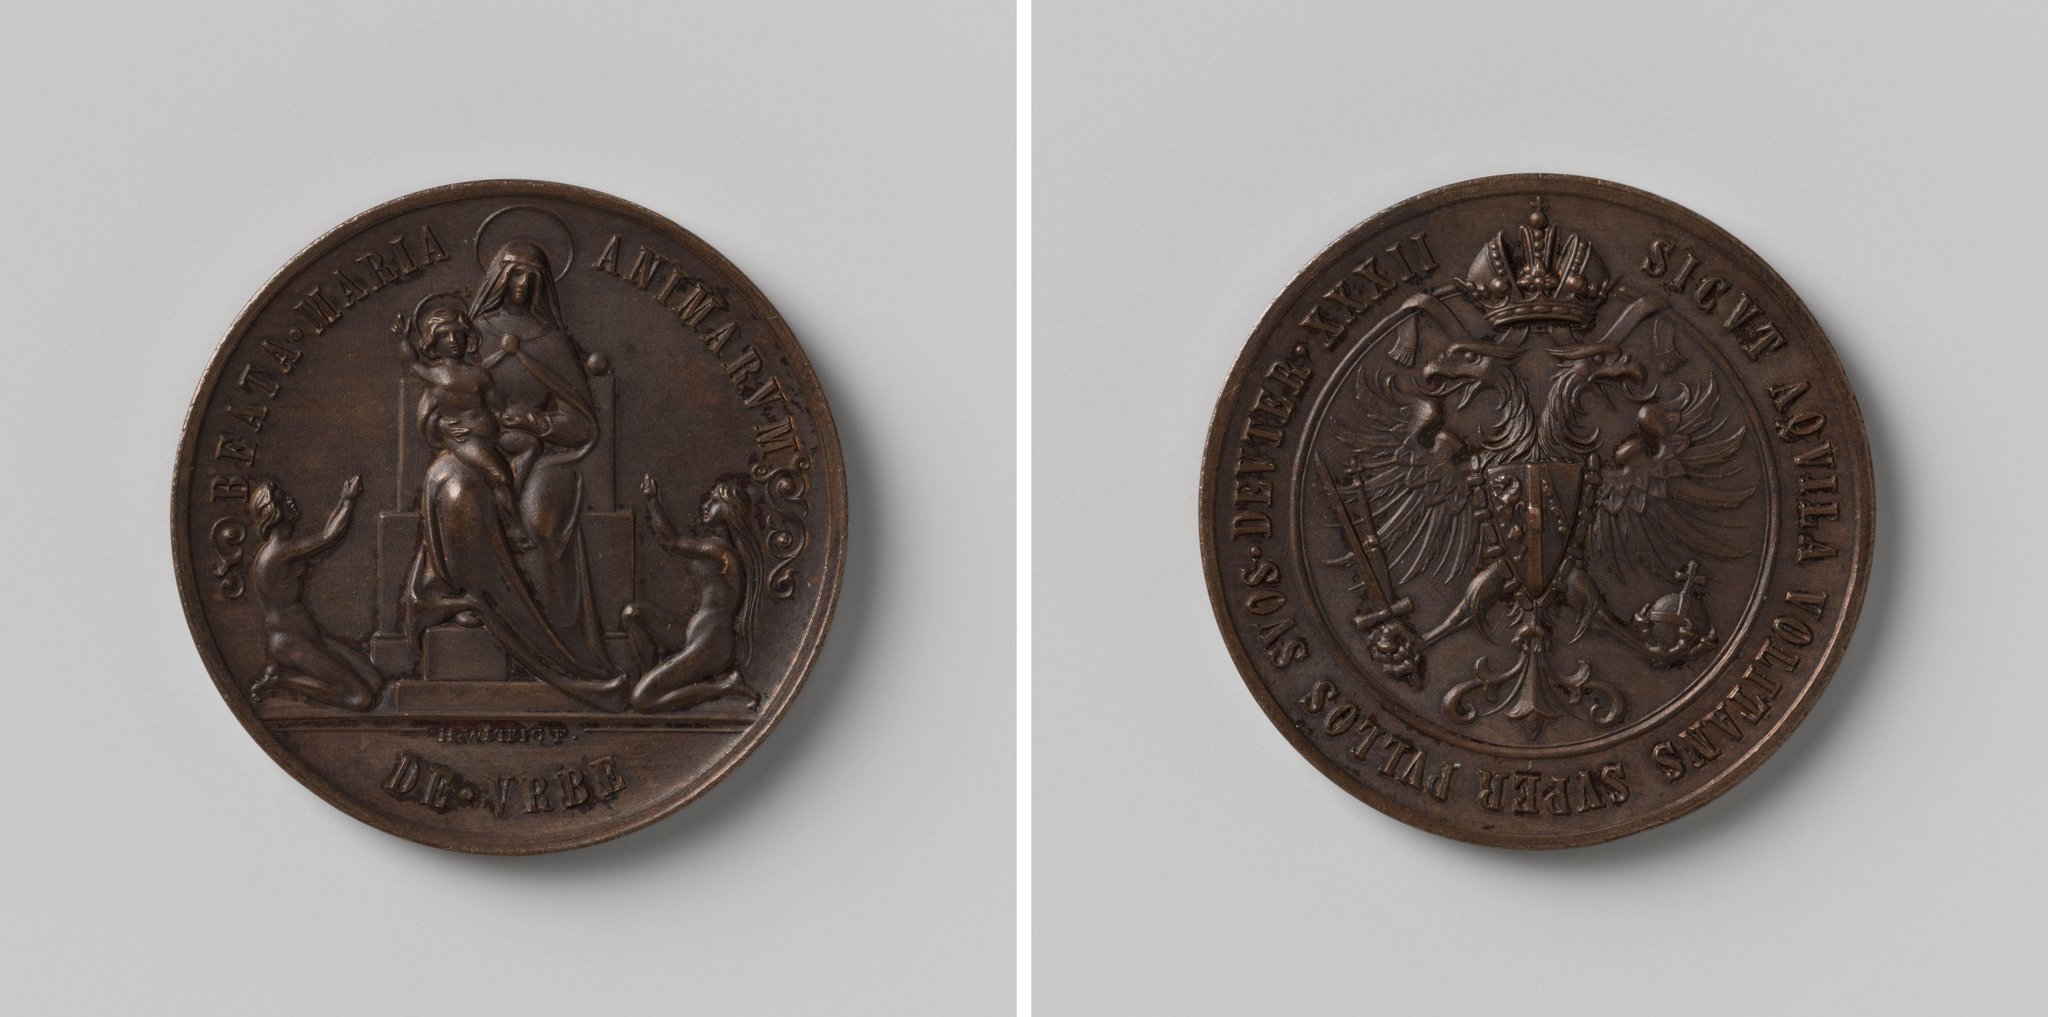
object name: devotional medal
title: Kerkelijke Oostenrijkse penning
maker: hermann wittig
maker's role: medailleur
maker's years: 1852-1889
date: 1880-1889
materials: bronze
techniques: striking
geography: rome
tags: austria, rome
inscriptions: circumscription: ‘SICVT AQVILA VOLITANS SVPER PVLLOS SVOS DEVTER XXXII’, signature: ‘H. WITTIG F. / DE - VBRE’, circumscription: ‘BEATA - MARIA ANIMARVM’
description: Bronzen penning. Voorzijde: twee smekelingen knielend voor troon, waarop Maria met kind is gezeten binnen omschrift; afsnede: opschrift en signatuur. Keerzijde: dubbelkoppige adelaar met twee zwaarden en rijksappel in klauwen onder kroon binnen omschrift.